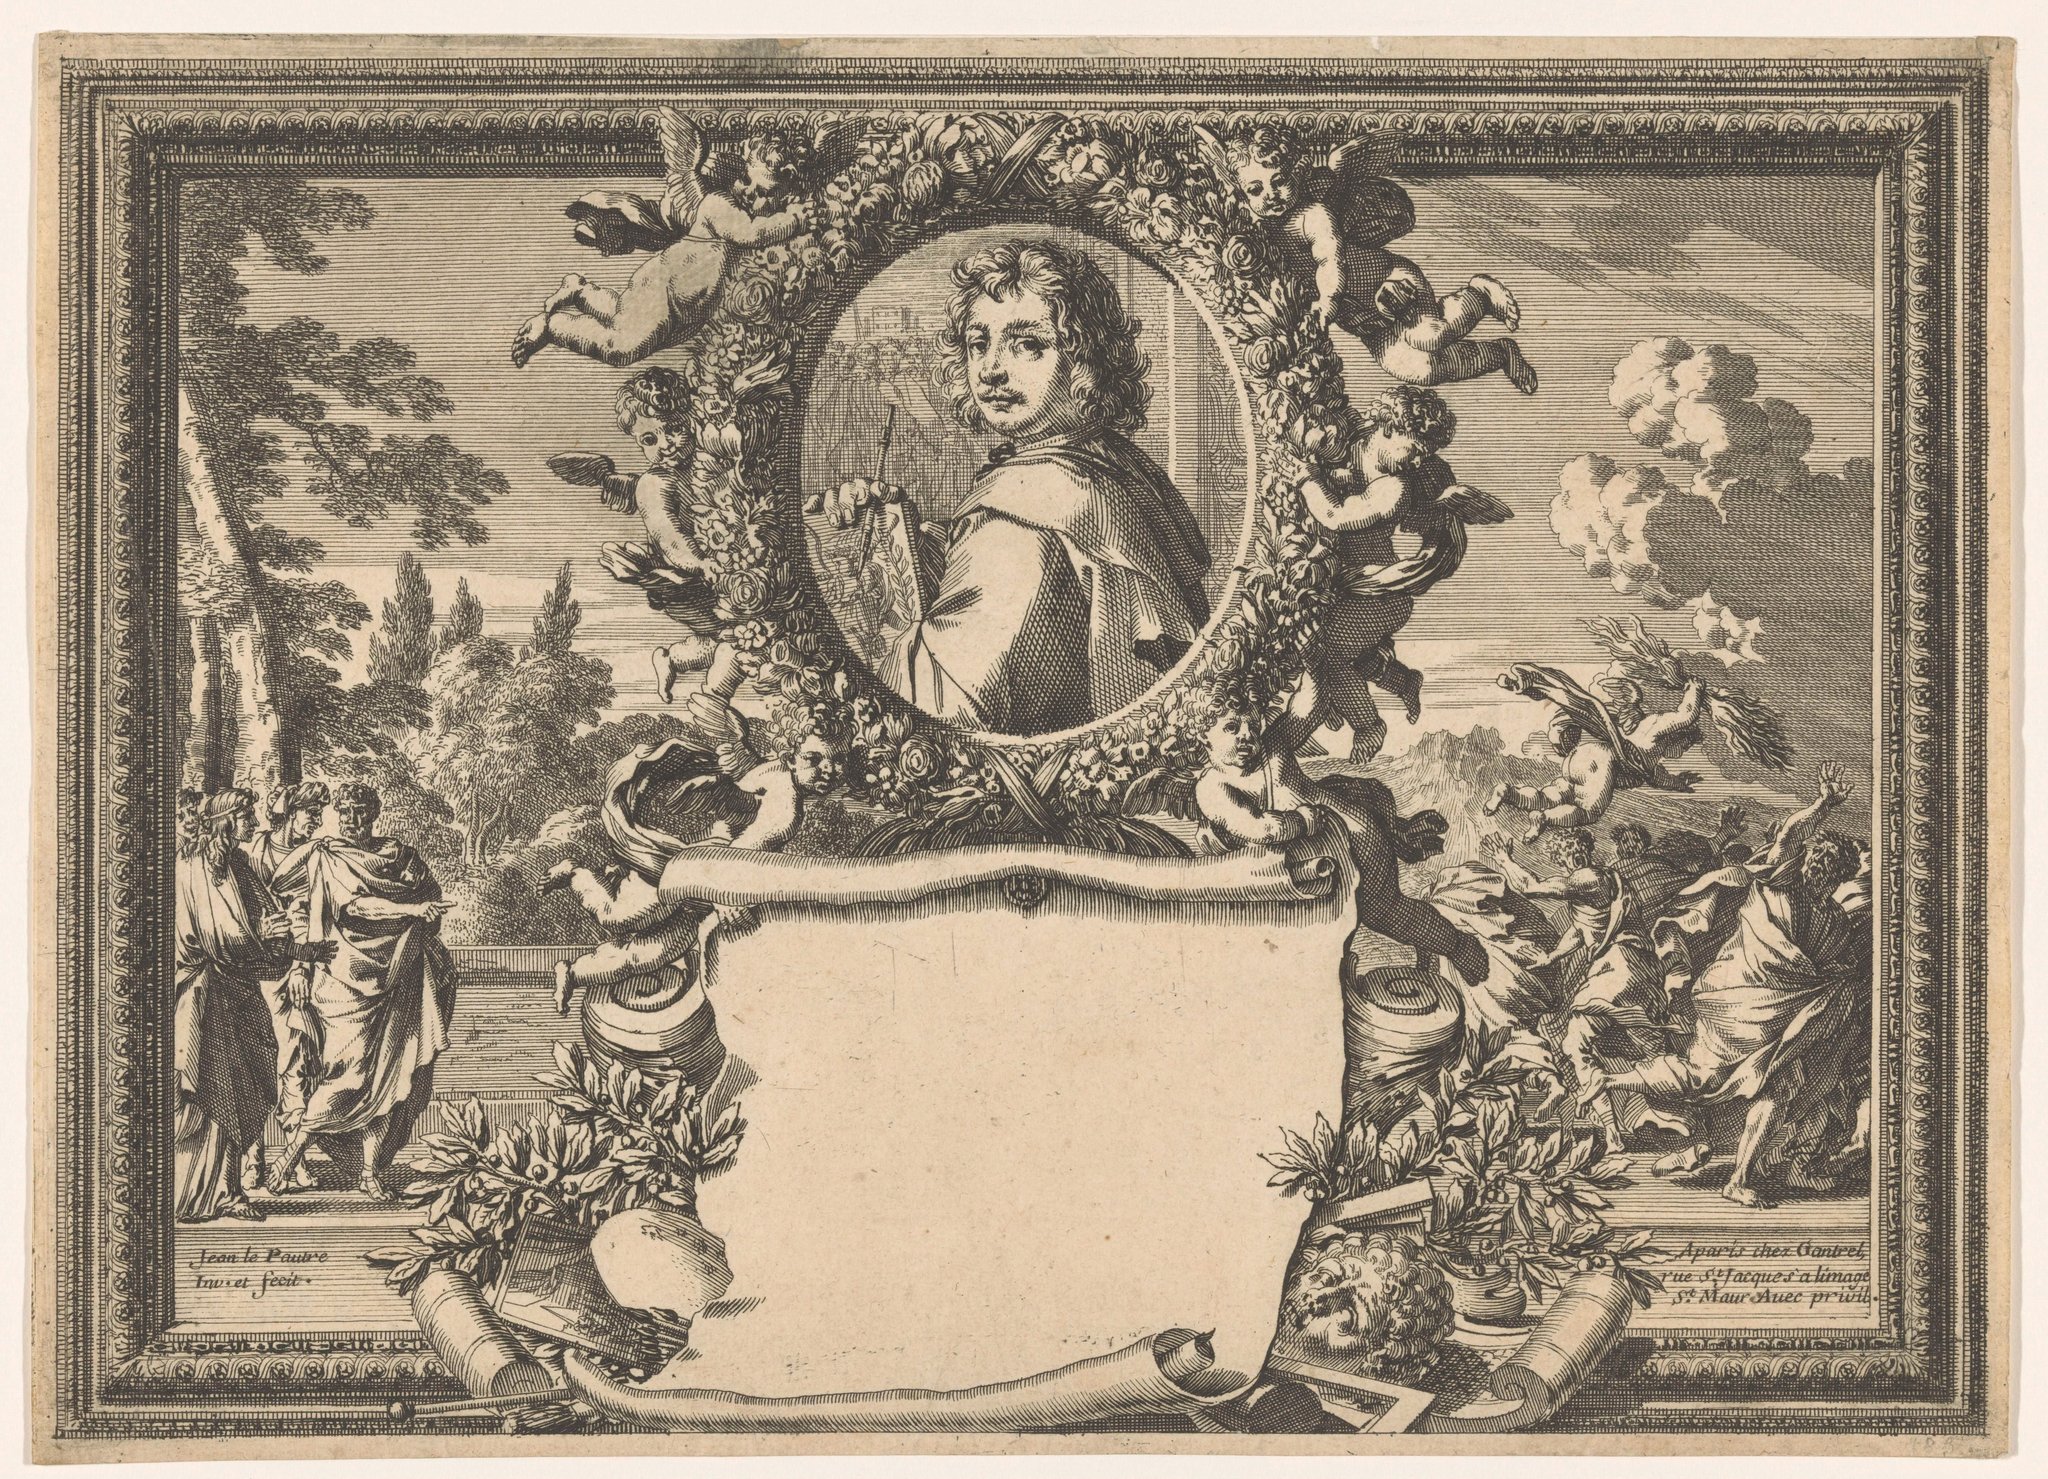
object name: print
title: Zelfportret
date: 1674-1682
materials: paper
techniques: etching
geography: paris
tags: paris, print maker, draughtsman, jean lepautre, engraver, etcher, tools, implements of graphic artist, cupids: 'amores', 'amoretti', 'putti', flowers ~ ornament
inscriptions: collector's mark: Lugt 4779, collector's mark: Lugt 2228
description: Zelfportret van Jean Lepautre met een etsnaald in zijn hand, buste in een ovale omlijsting met bloemen omhooggehouden door putti. Daaronder een leeg vel omgeven door kunstenaarsattributen. Rechts verjaagt een putto een groep mannen, links vier mannen voor een muurtje met daarachter bomen.